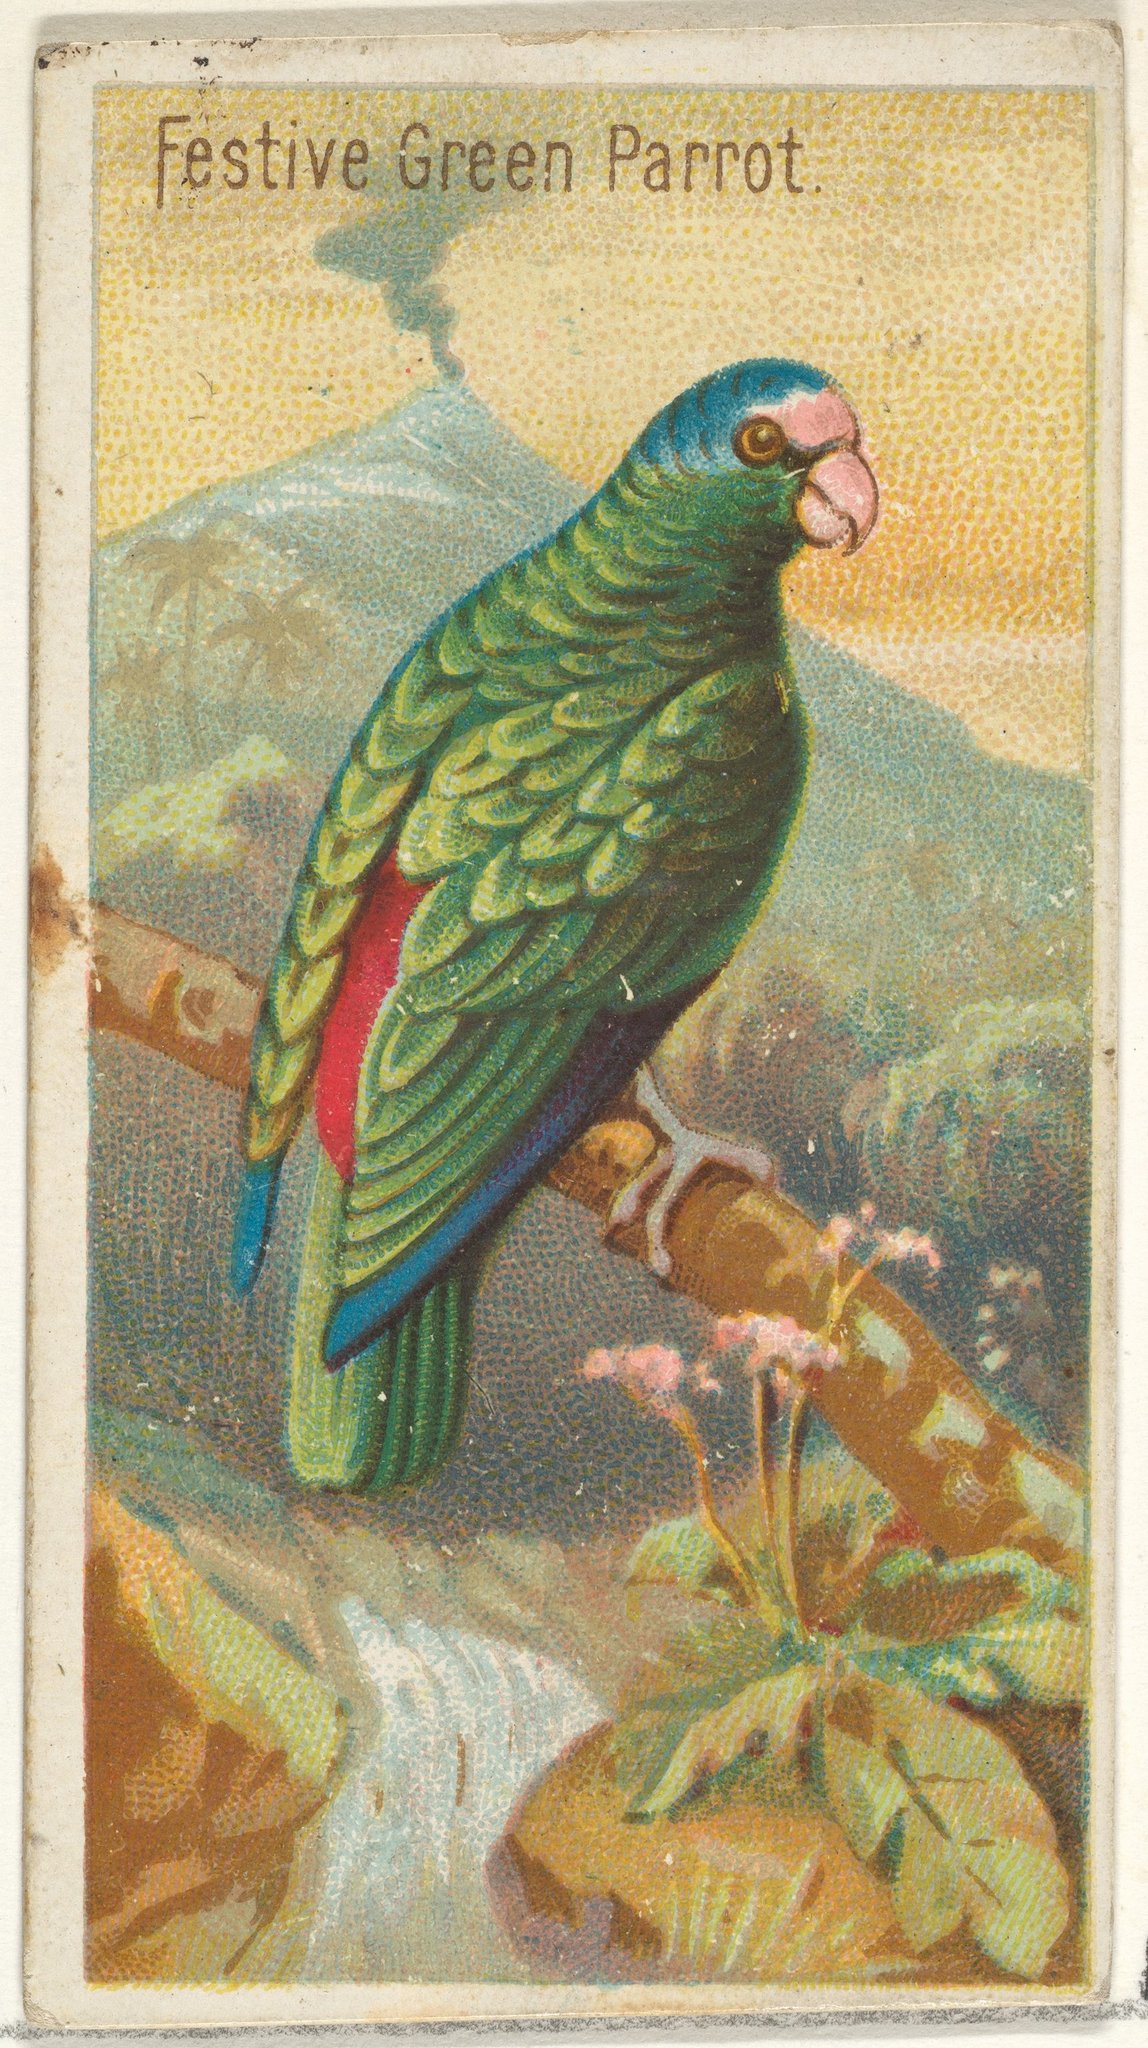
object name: print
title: Festive Green Parrot, from the Birds of the Tropics series (N5) for Allen & Ginter Cigarettes Brands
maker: allen & ginter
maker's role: publisher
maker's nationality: american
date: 1889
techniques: color lithograph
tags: parrots